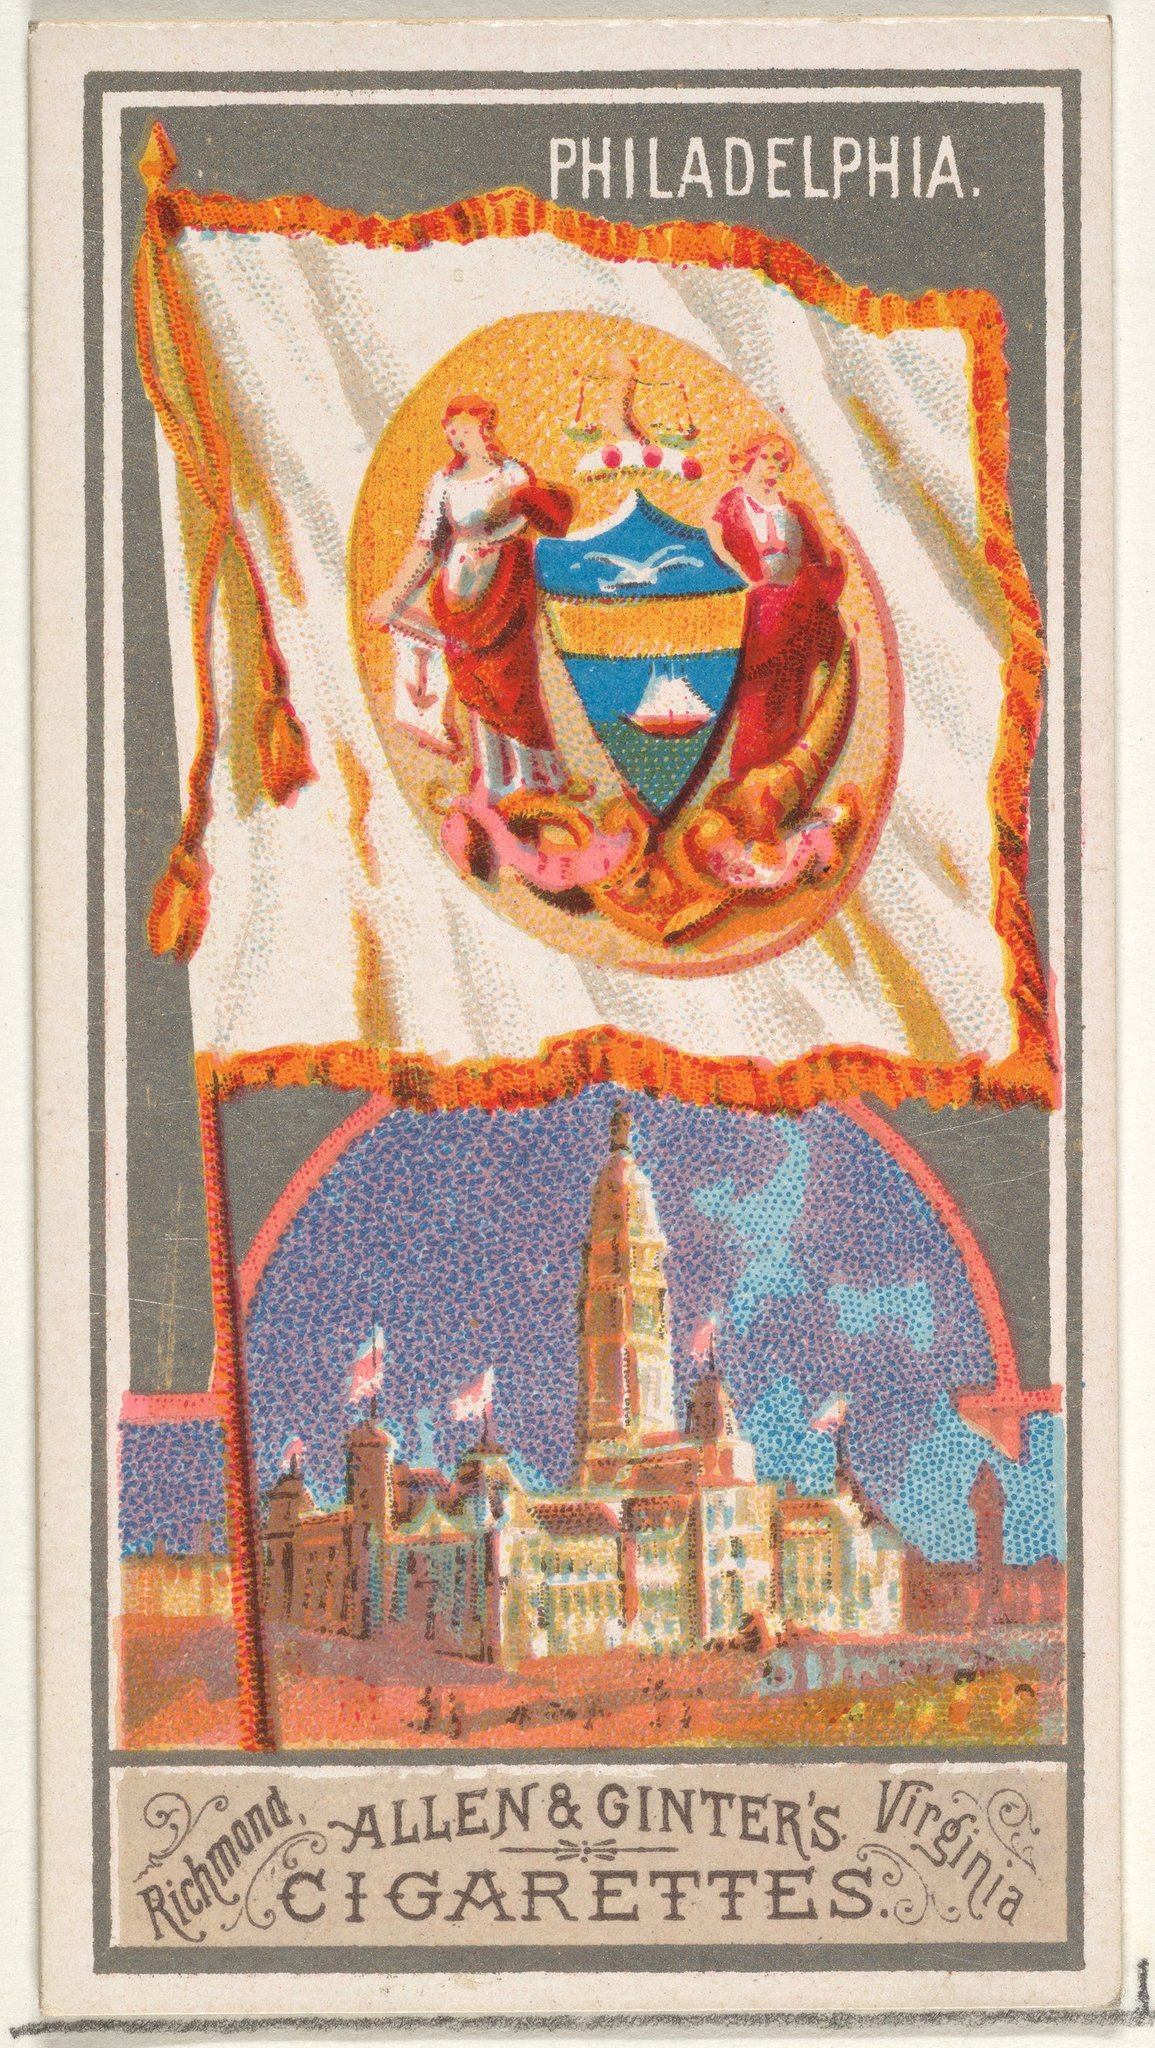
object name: print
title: Philadelphia, from the City Flags series (N6) for Allen & Ginter Cigarettes Brands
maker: allen & ginter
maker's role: publisher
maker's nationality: american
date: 1887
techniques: color lithograph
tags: flags